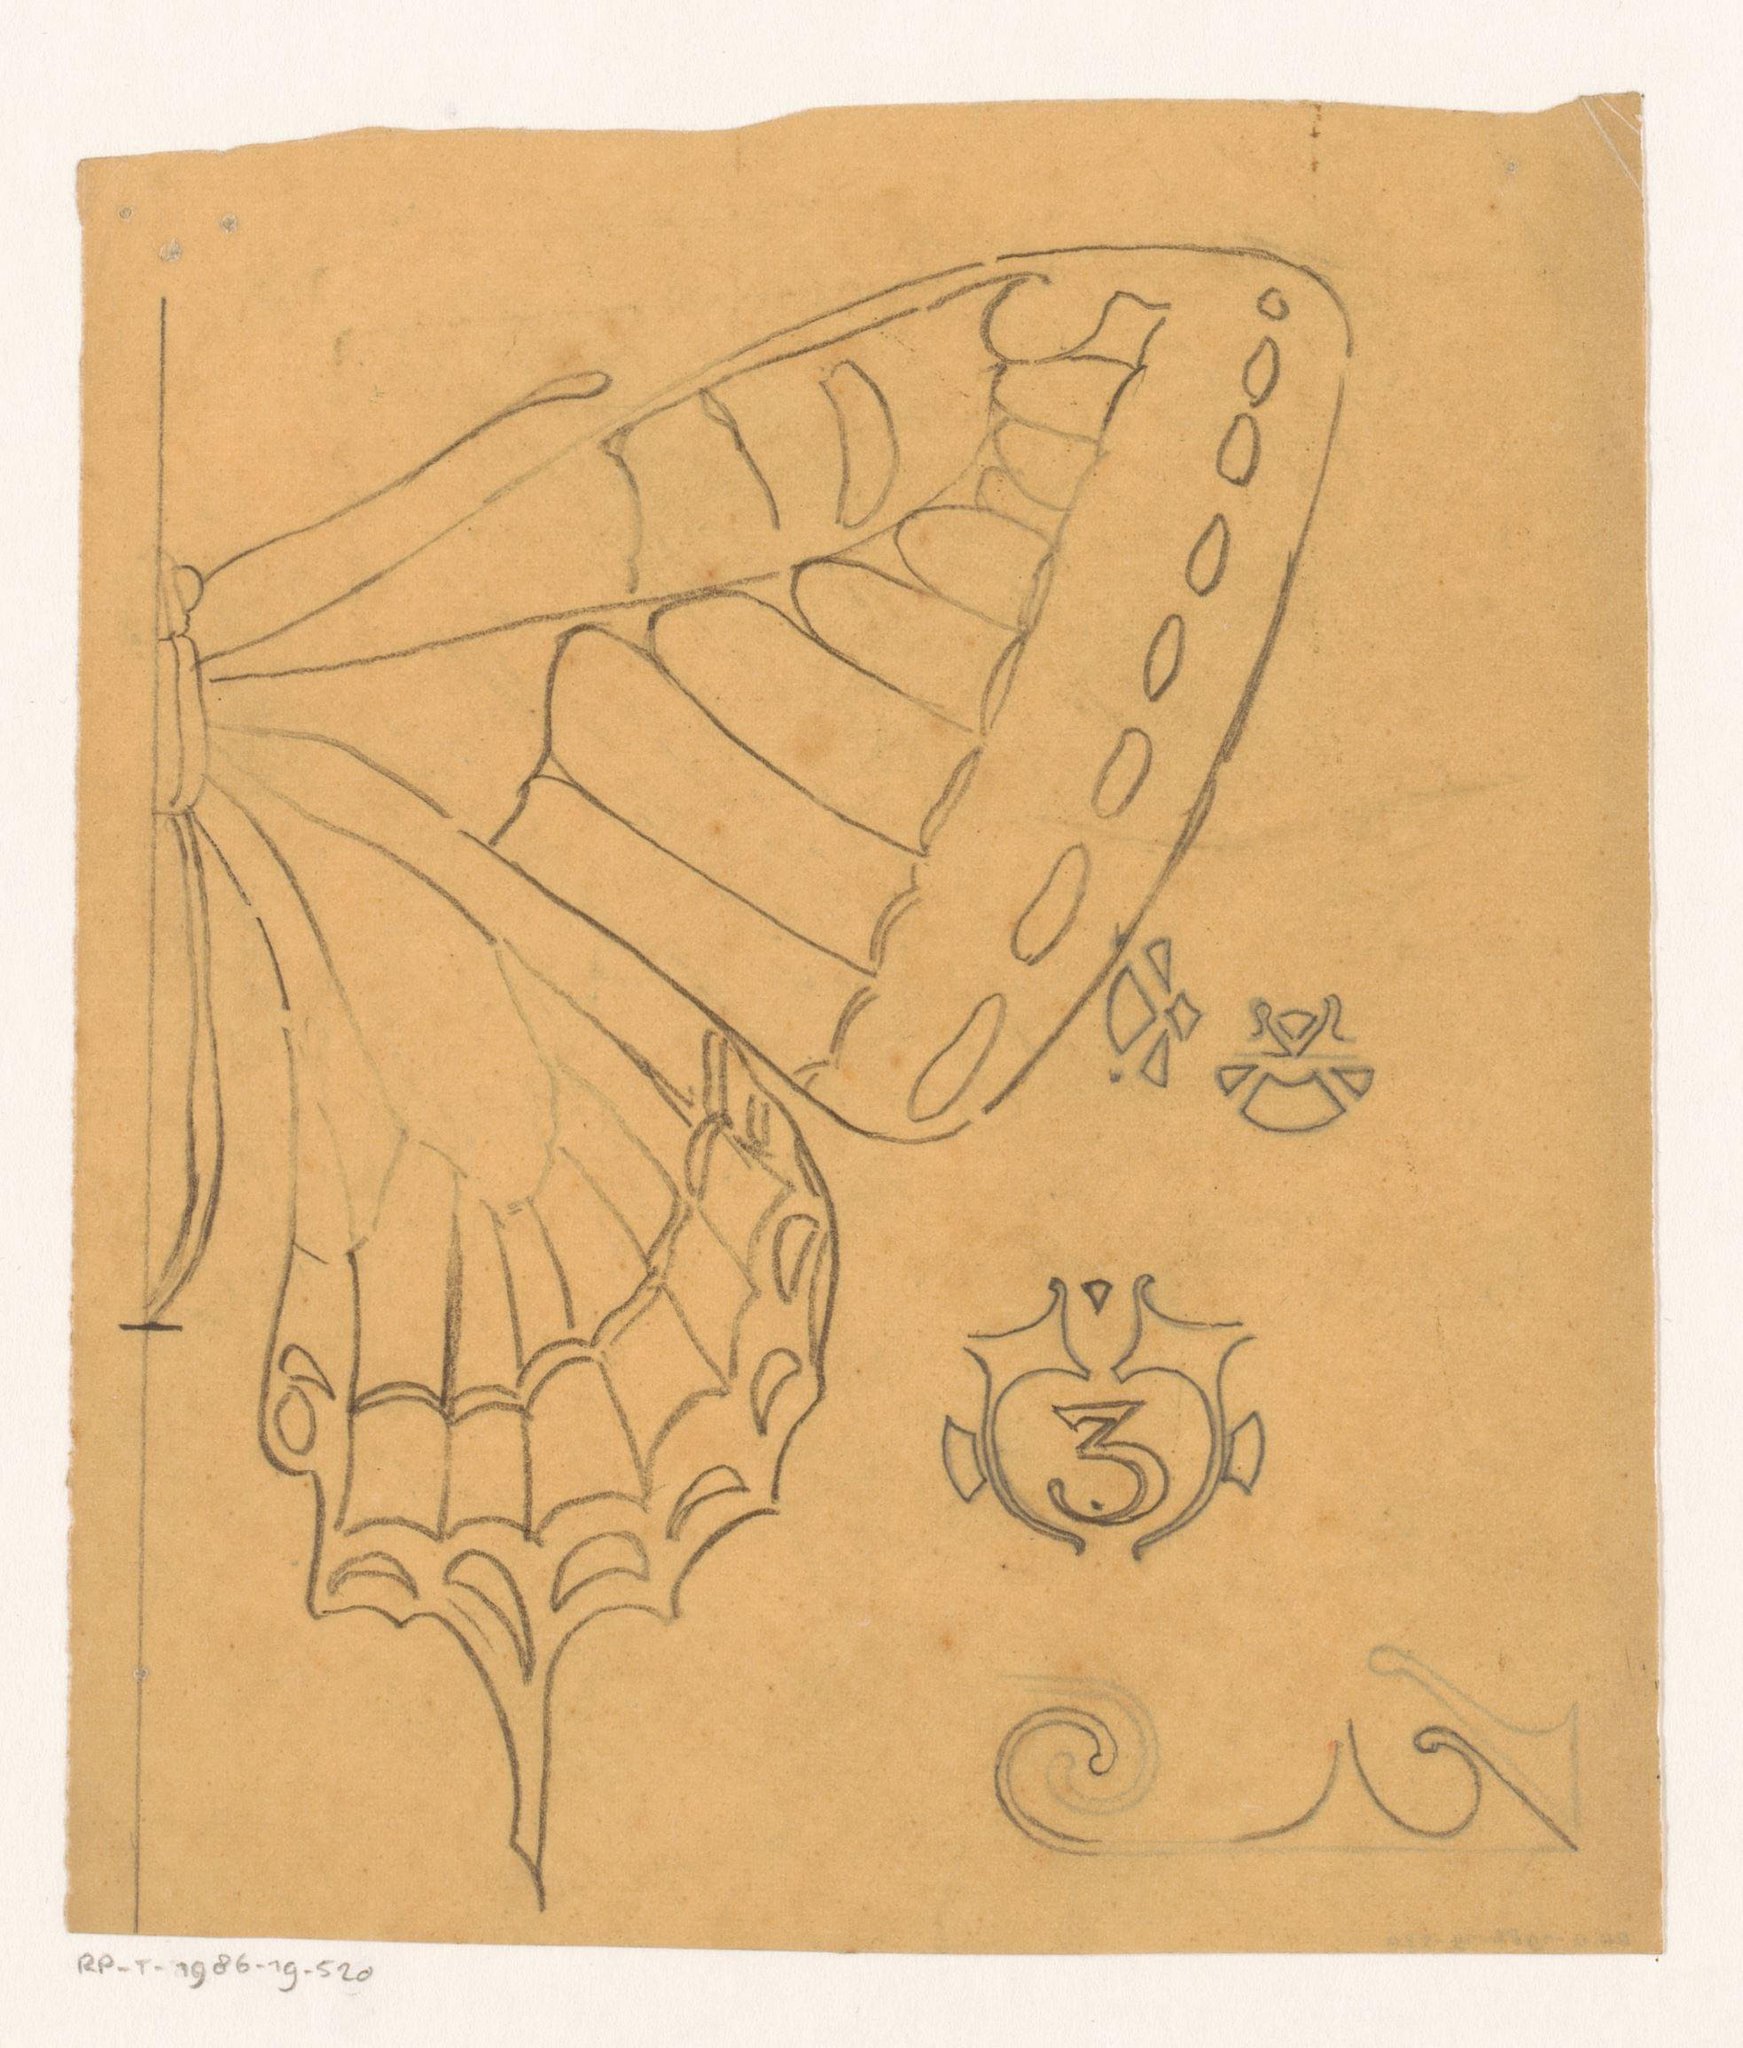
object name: drawing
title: Vlinder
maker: reinier willem petrus de vries (1874-1953)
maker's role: draughtsman, print maker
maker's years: 1874-1953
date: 1884-1952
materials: pencil, paper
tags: insects: butterfly